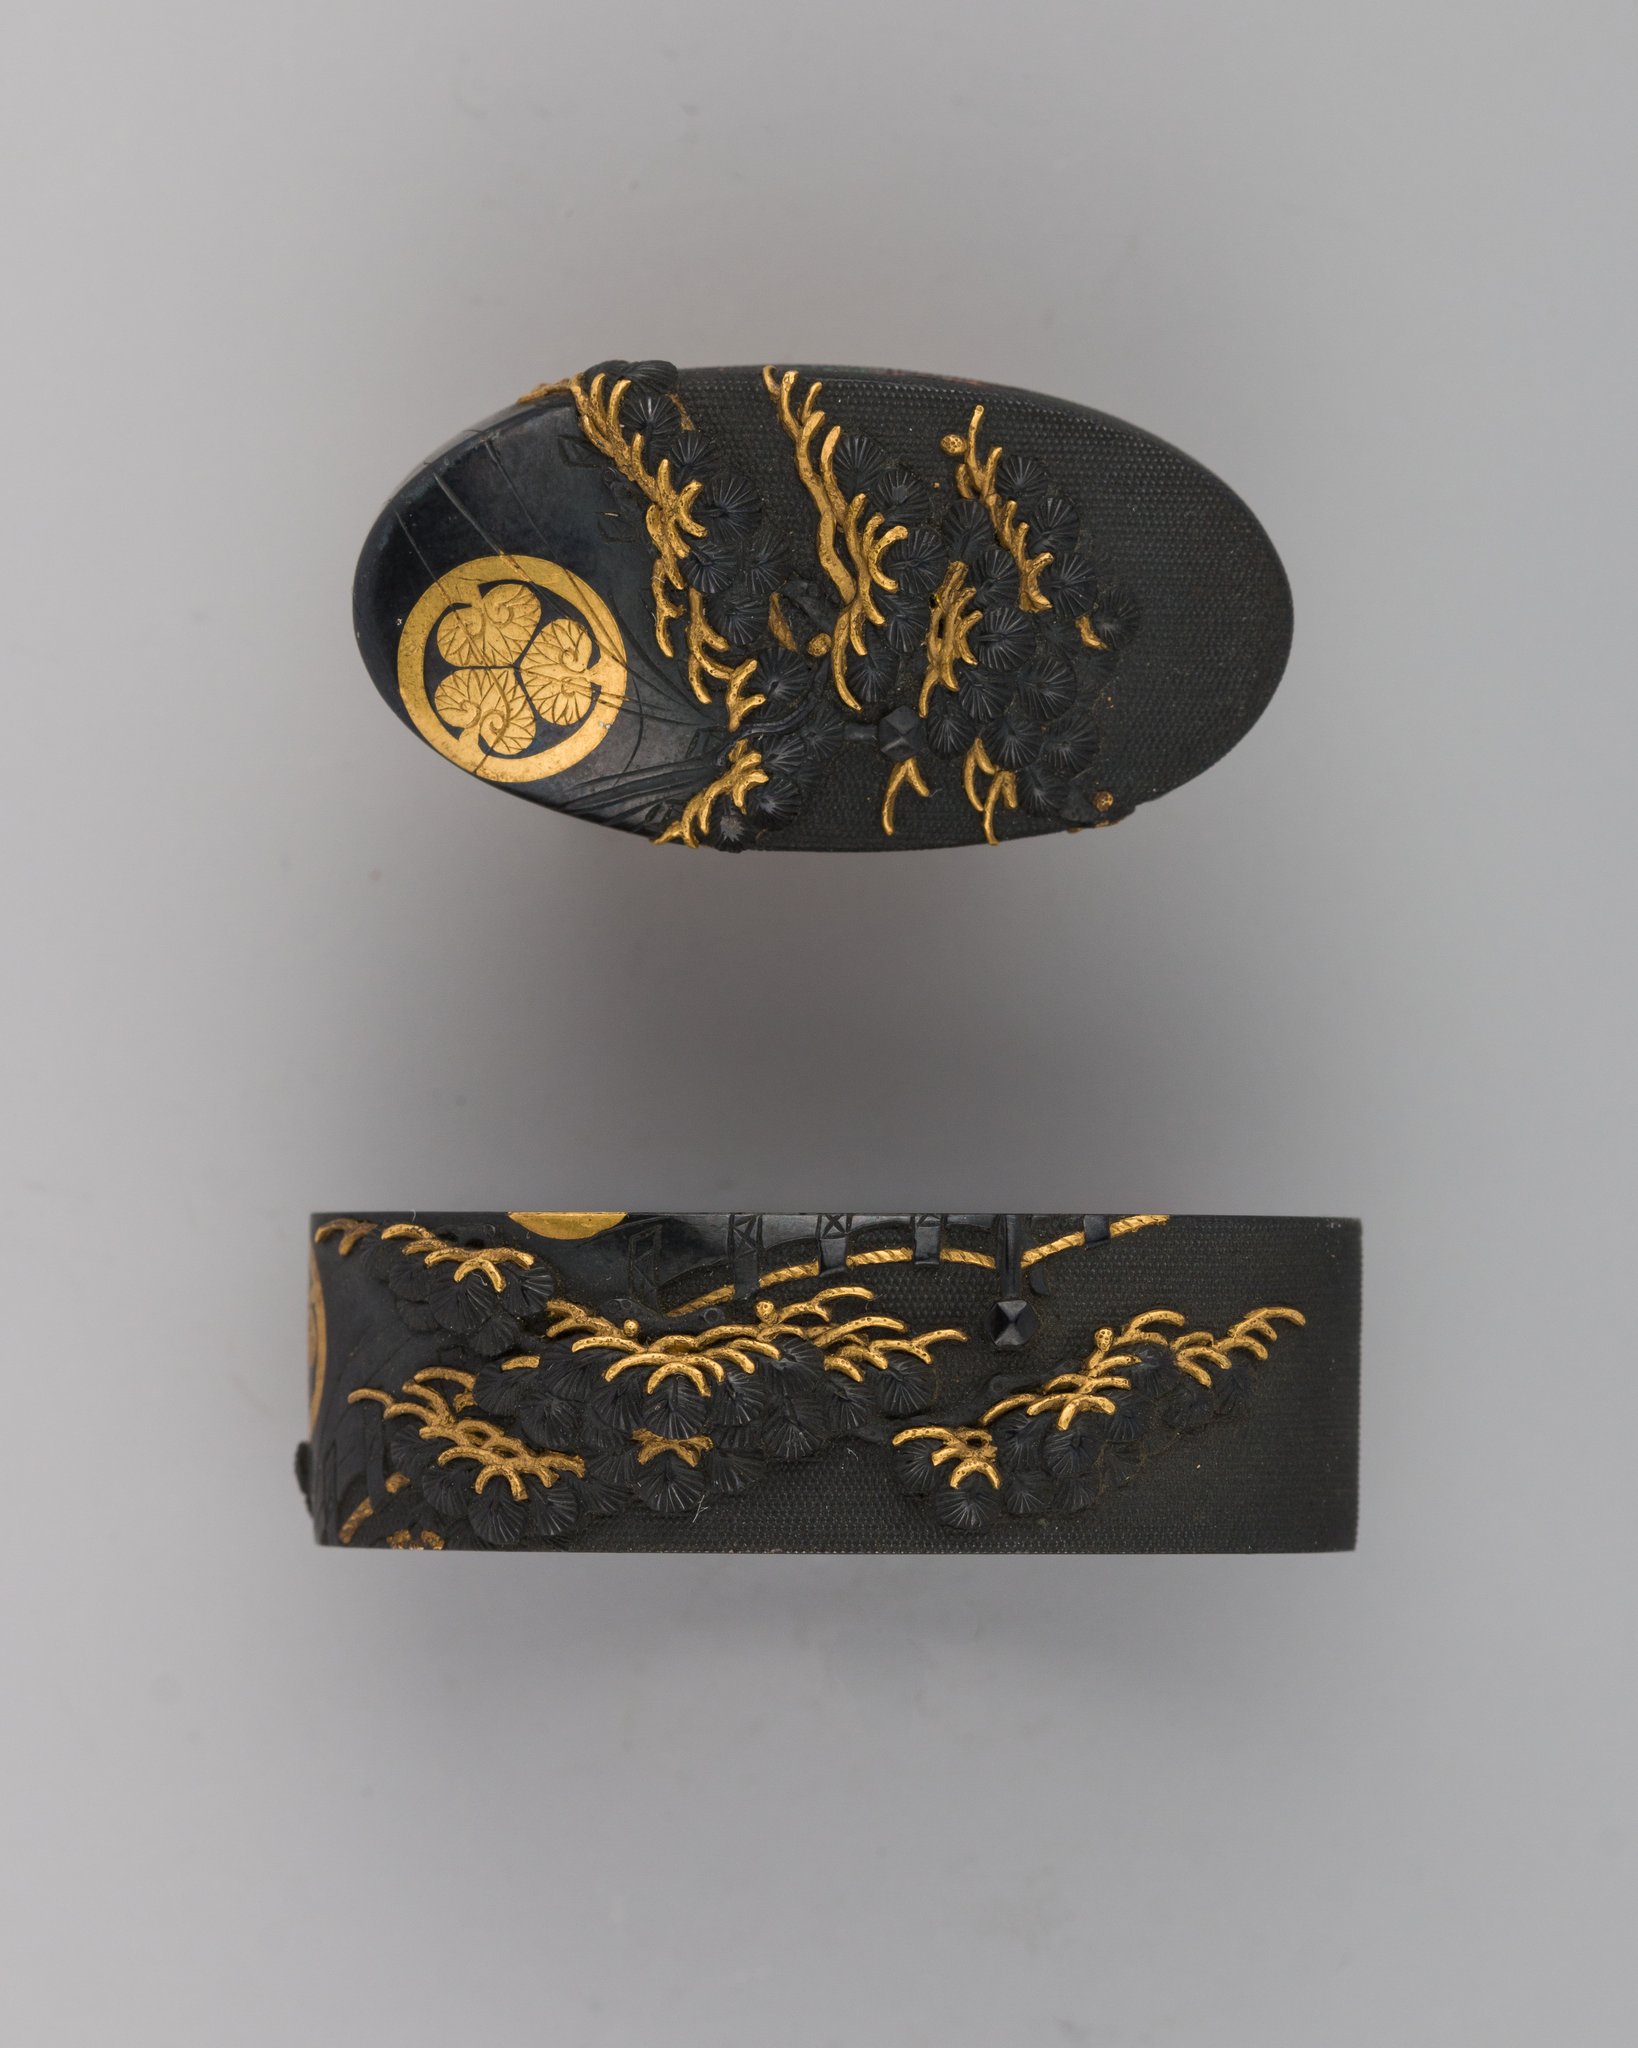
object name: sword hilt collar and pommel fuchigashira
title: Sword-Hilt Collar and Pommel (Fuchigashira)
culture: japanese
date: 1615-1868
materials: gold alloy, gold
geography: japan